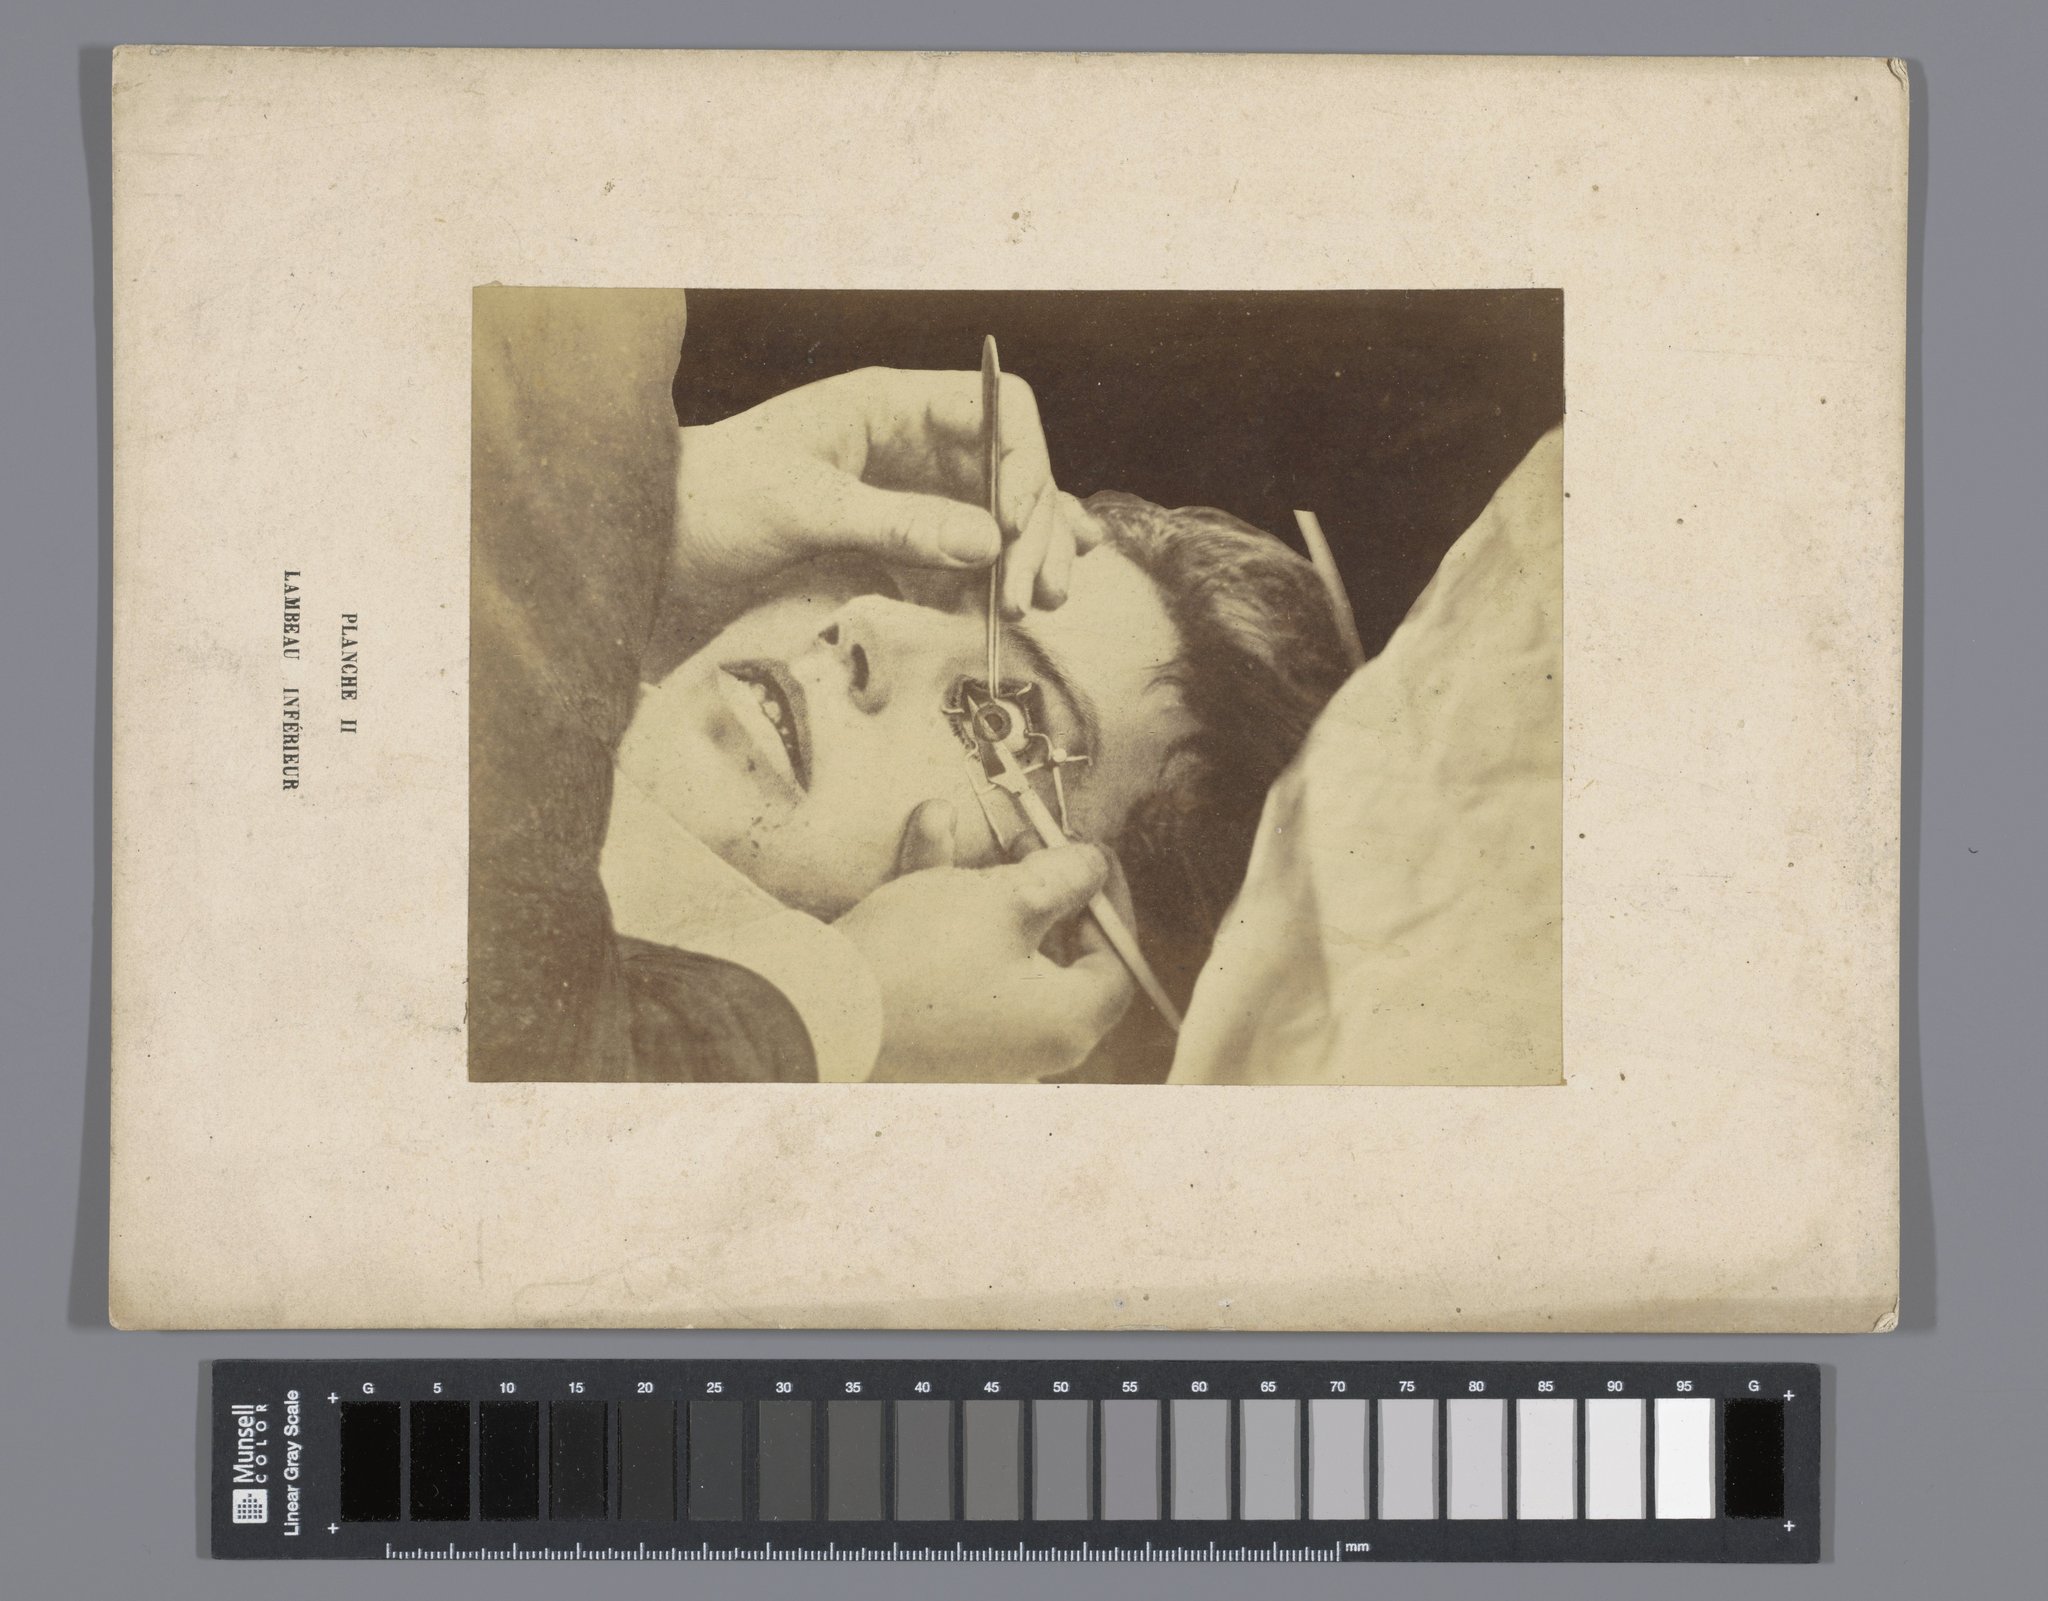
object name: page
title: Lambeau inférieur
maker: a. de montméja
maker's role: arts, fotograaf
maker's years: 1841-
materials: photographic support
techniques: albumen print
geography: france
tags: eyes, operation, surgery, disabilities affecting the eyes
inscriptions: number: ‘Planche II’